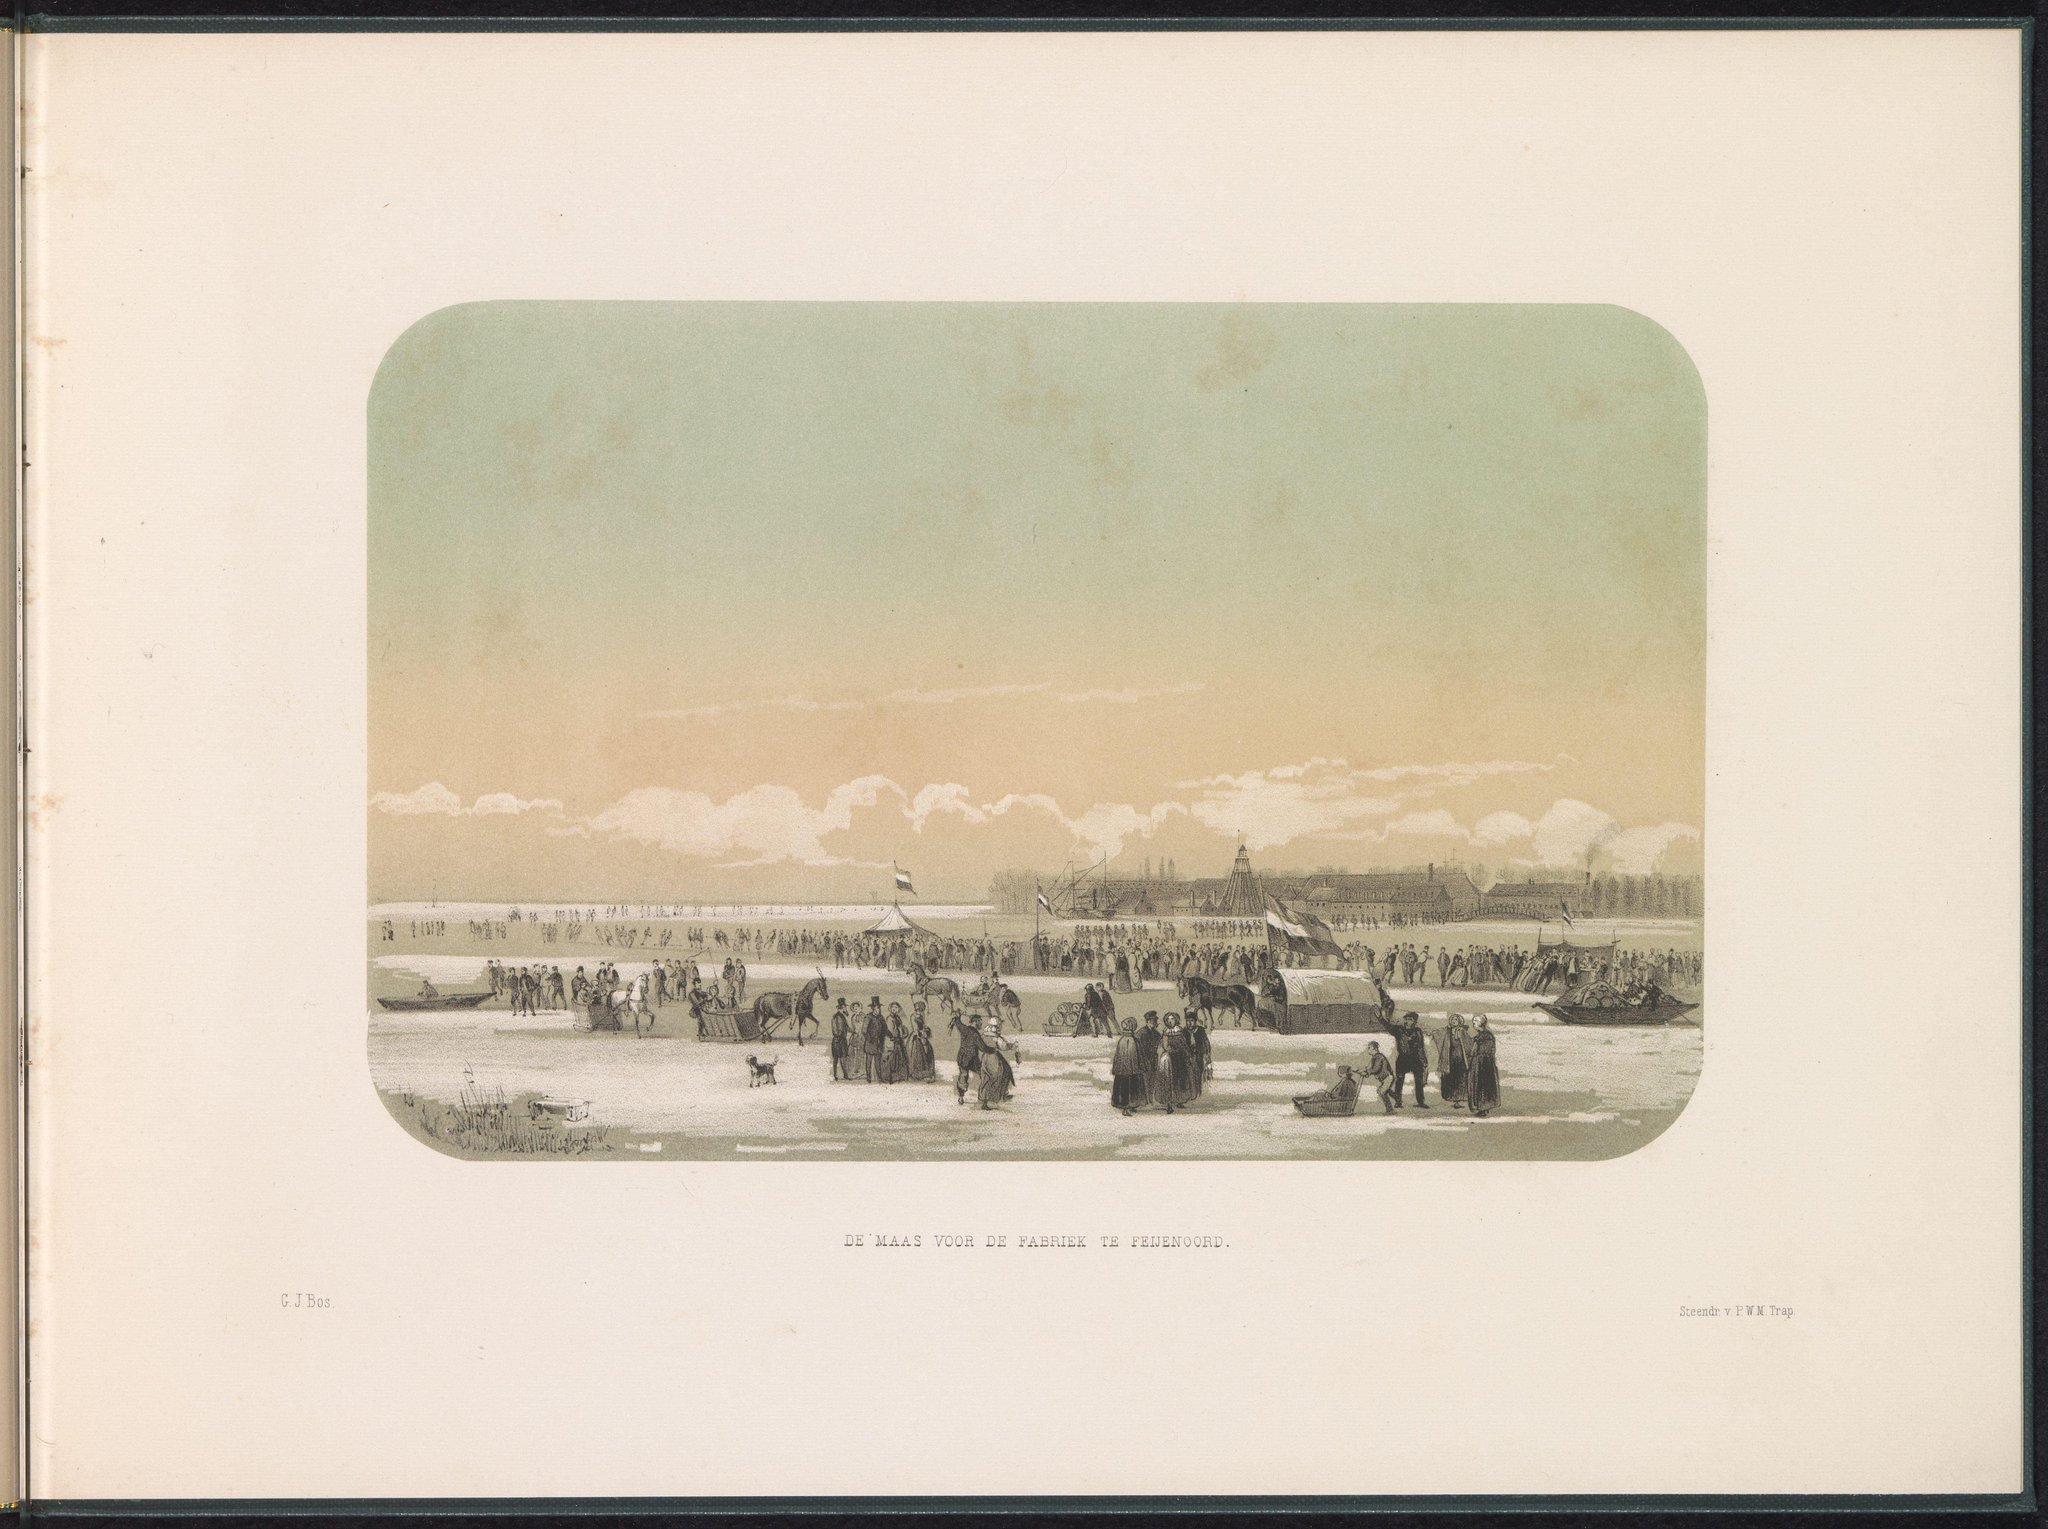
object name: print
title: Het ijsvermaak op de Maas te Rotterdam in Februari 1855, met bijschriften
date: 1855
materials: paper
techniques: lithograph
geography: leiden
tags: winter sports, playing with snow and ice, rotterdam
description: IJsvermaak op de Maas te Rotterdam, in de verte de fabriek te Feijenoord. Zesde plaat in een boek met zes platen over het ijsvermaak op de Maas te Rotterdam in februari 1855. Dit exemplaar in 1861 heruitgegeven ten behoeve van de slachtoffers van de watersnood.